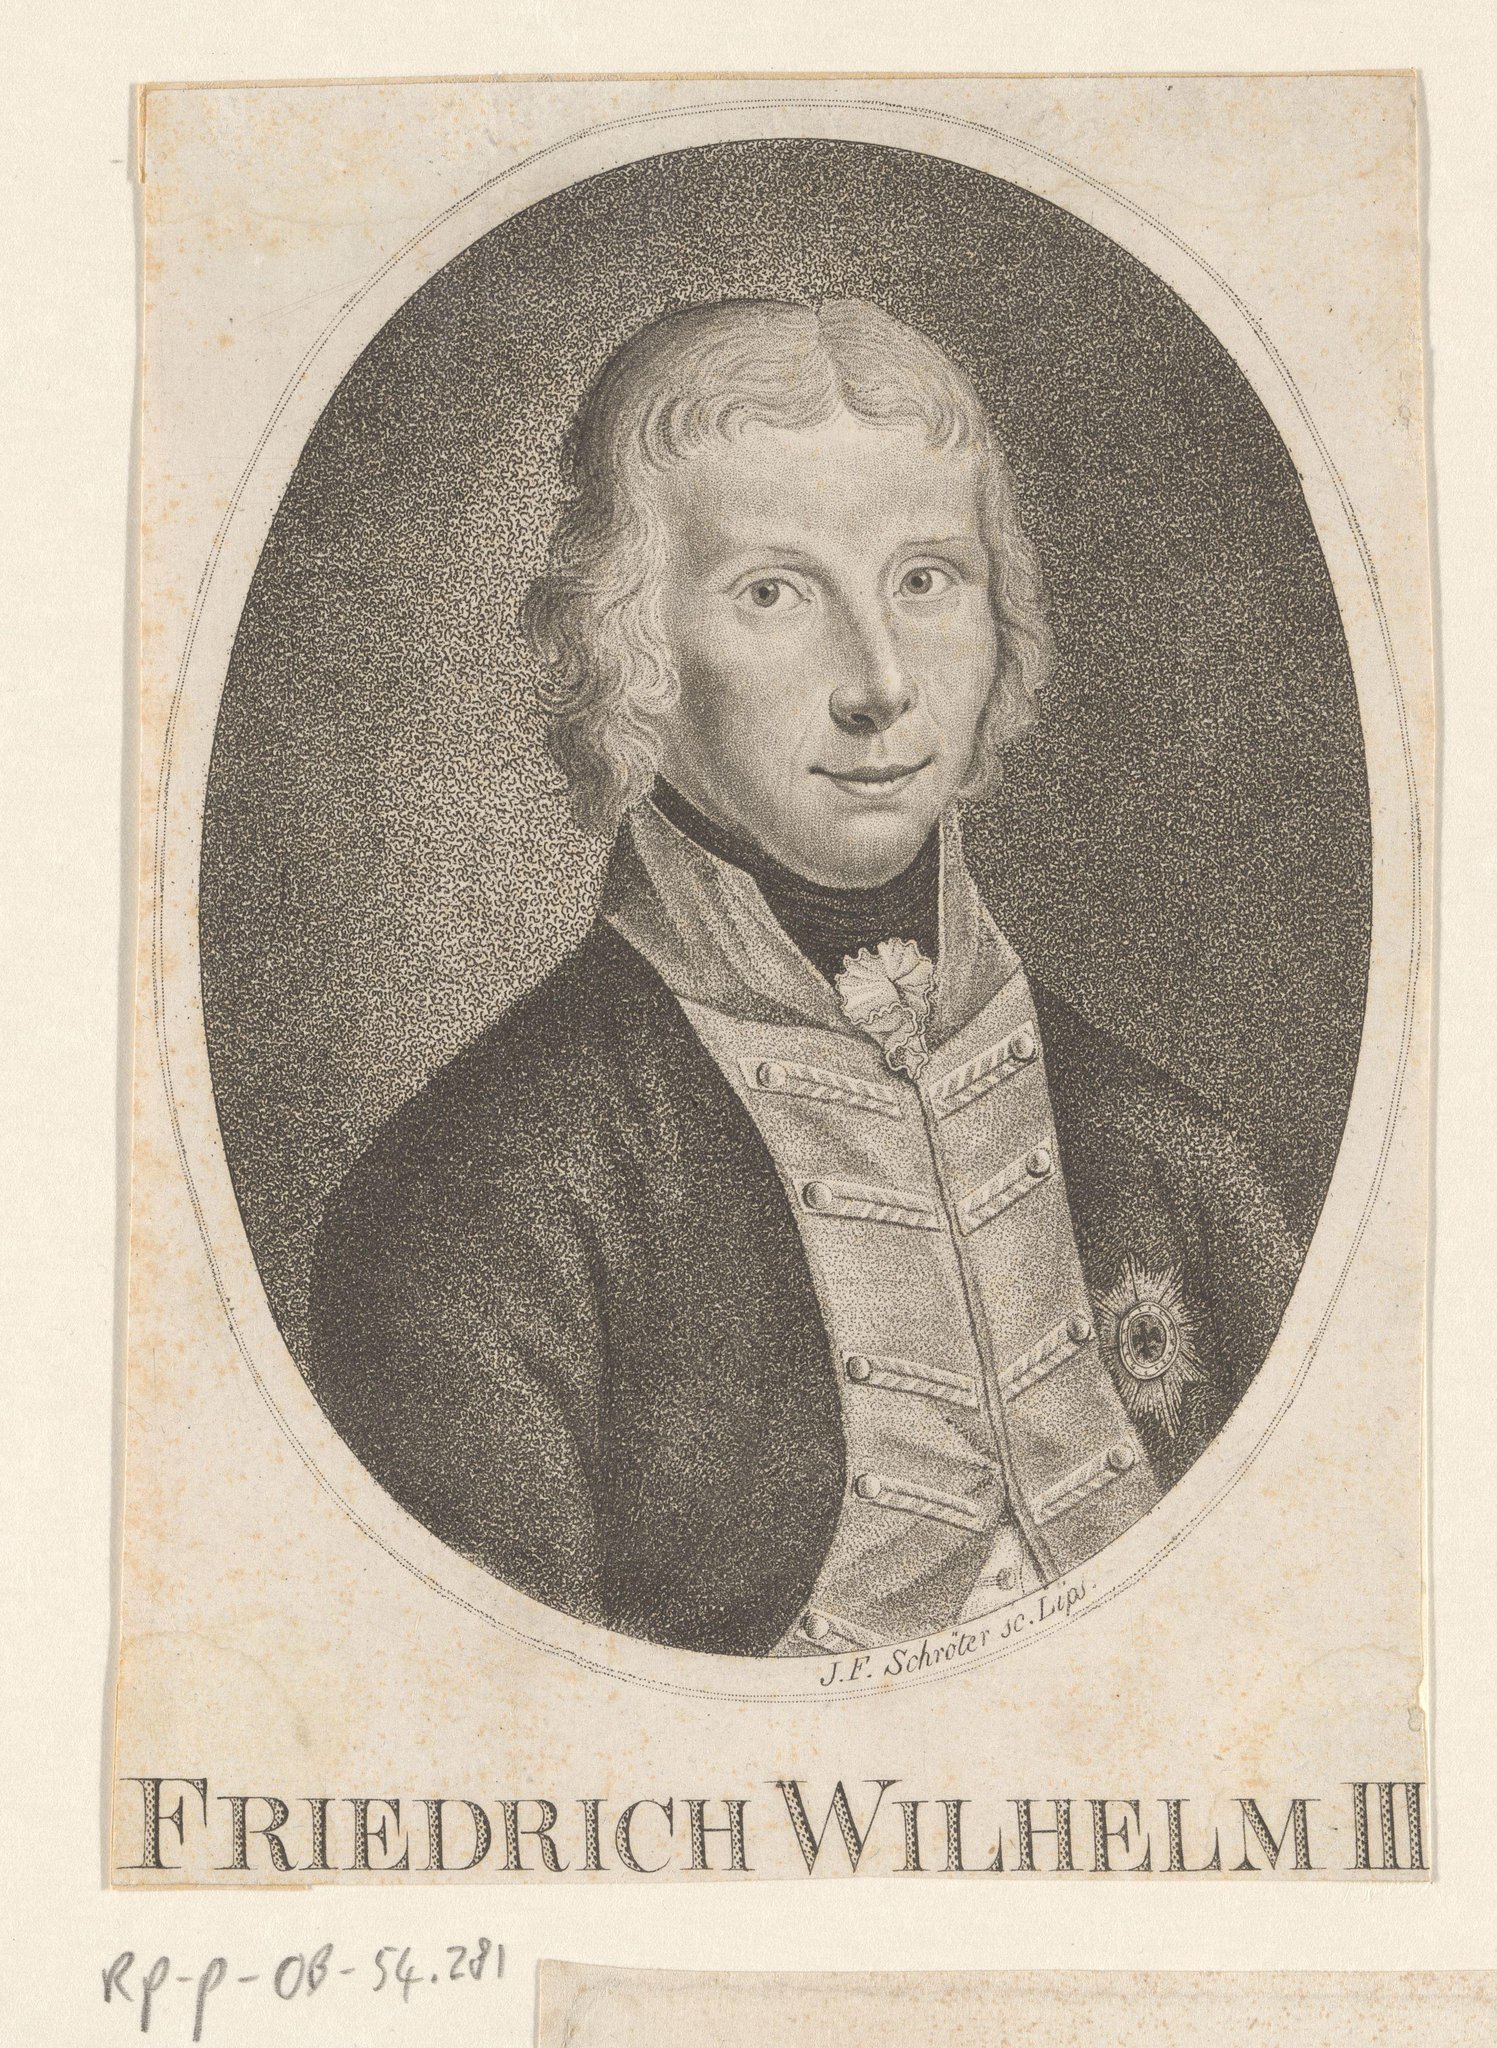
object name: print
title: Portret van Frederik Willem III, koning van Pruisen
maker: johan friedrich schrötter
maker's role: print maker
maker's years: 1770-1836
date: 1780-1836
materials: paper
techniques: engraving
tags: berlin, frederik willem iii koning van pruisen, historical persons